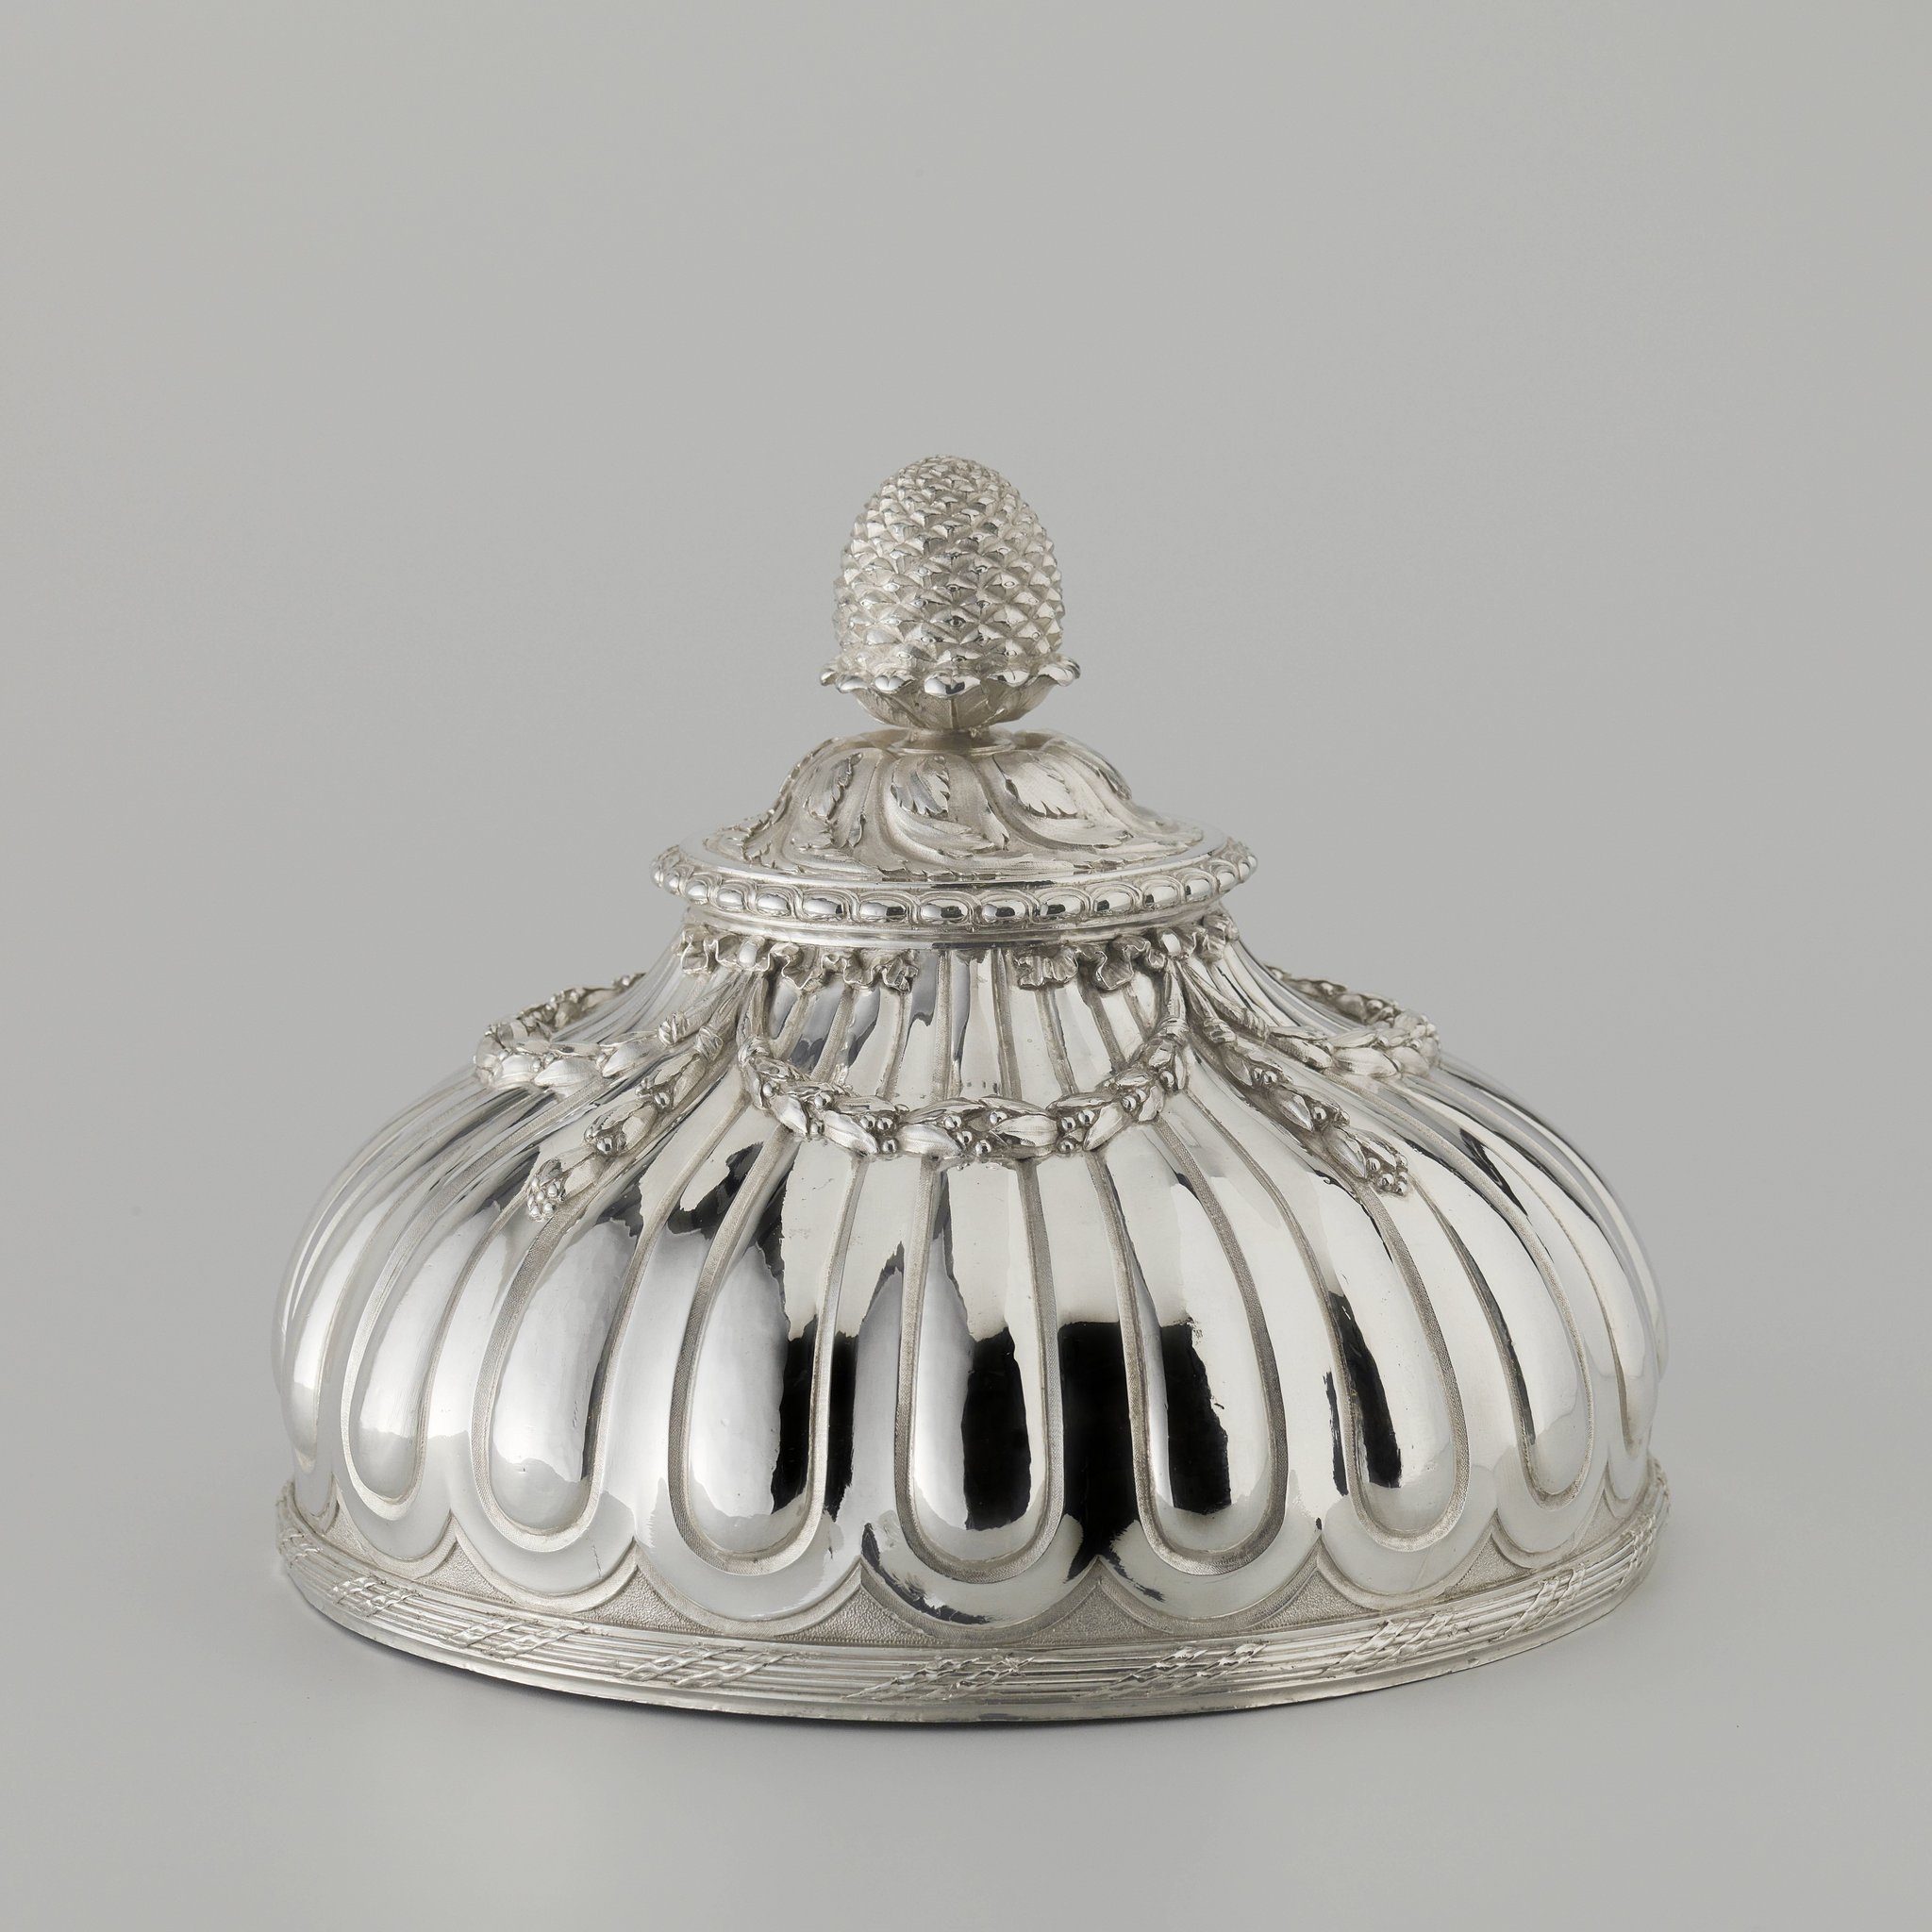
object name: lid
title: Deksel van zilver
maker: jacques-nicolas roëttiers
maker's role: silversmith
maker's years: 1732-1786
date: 1772-1773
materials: silver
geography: paris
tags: catharina de grote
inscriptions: duty mark, date letter, silver mark, alloy mark, inscription: ‘67’, maker's mark, inscription: ‘No 67’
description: Ronde, hoge deksel van zilver. Koepelvormig en naar het midden toe oplopend en bekroond door een ananas als knop.